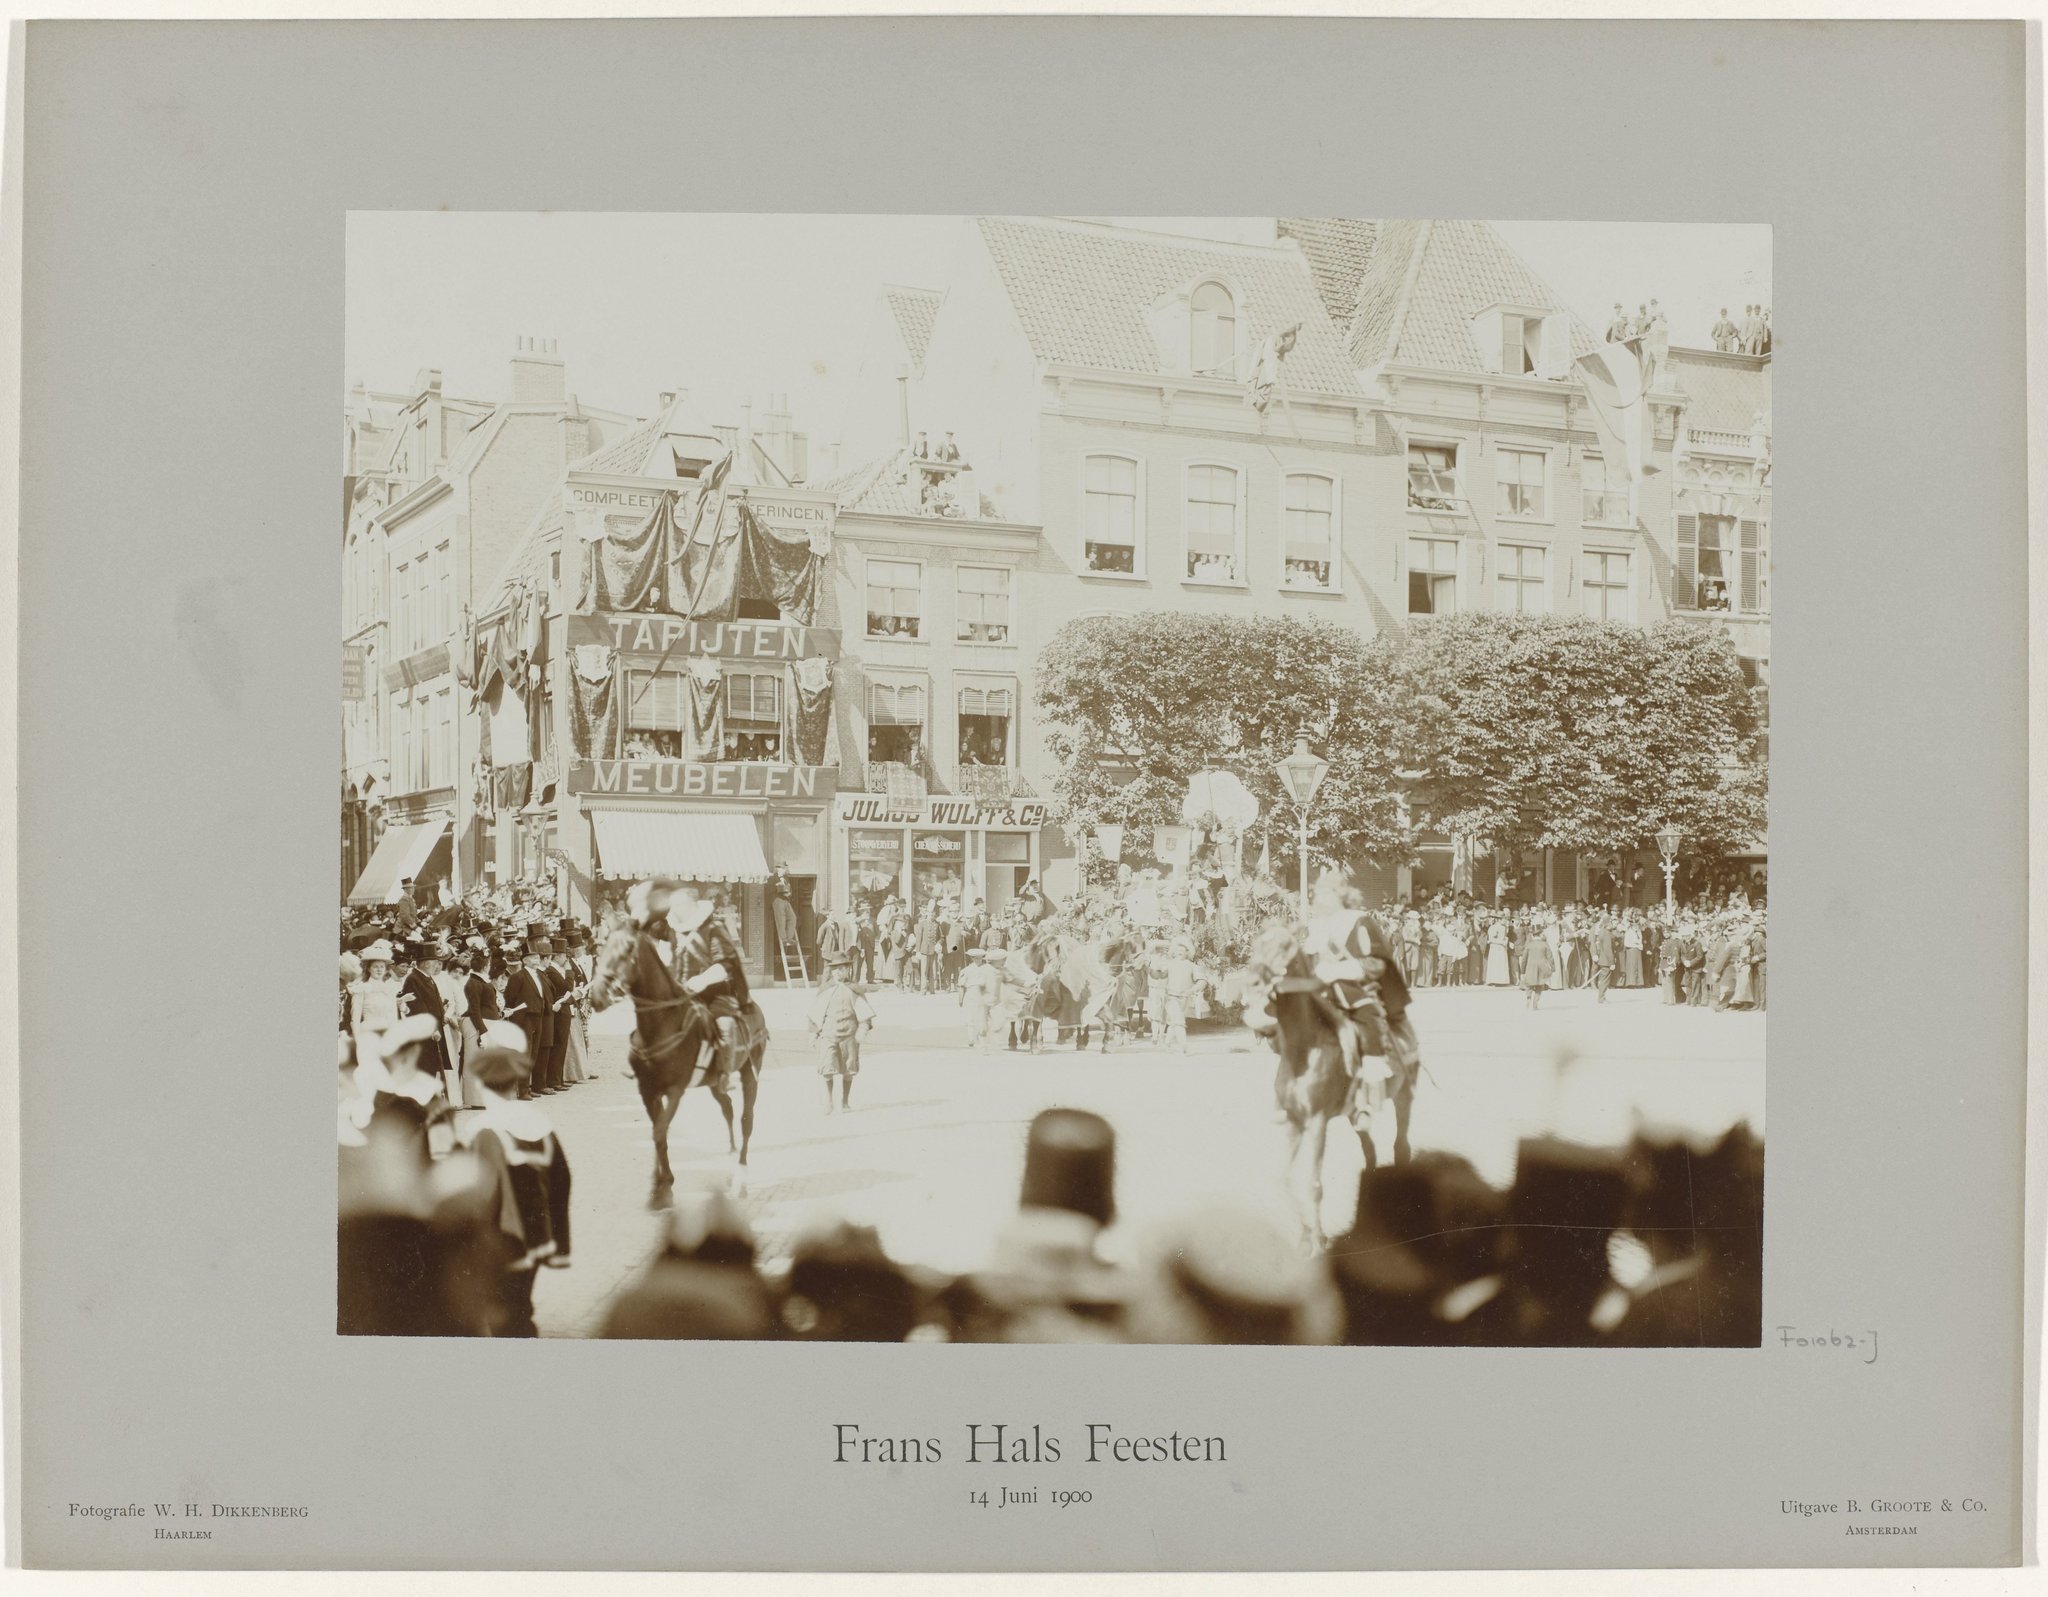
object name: photograph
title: Optocht op de Grote Markt te Haarlem ter gelegenheid van de Frans Hals Feesten op 14 juni 1900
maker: willem hendrik dikkenberg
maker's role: fotograaf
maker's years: 1872-1946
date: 1900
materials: photographic support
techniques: collodion silver print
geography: grote markt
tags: riding a horse, ass, or mule; rider, horseman, advertising, public festivities, military parade, pageant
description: Onderdeel van Fotoalbum met opnames van de Frans Hals Feesten in Haarlem op 14 juni 1900.